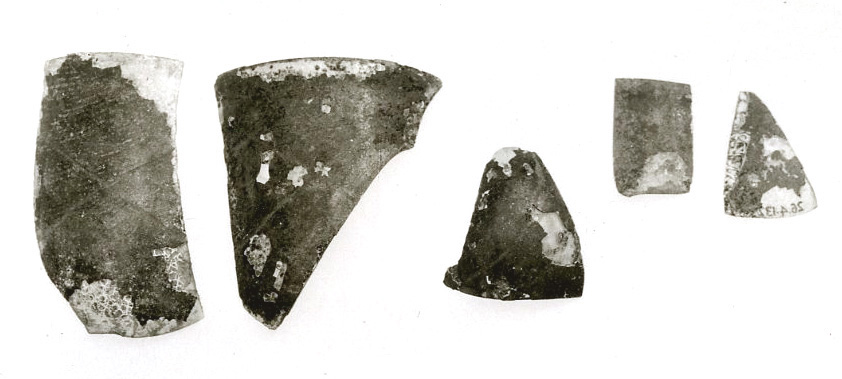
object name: fragment of a jar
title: Jar, fragments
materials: glass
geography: nubia